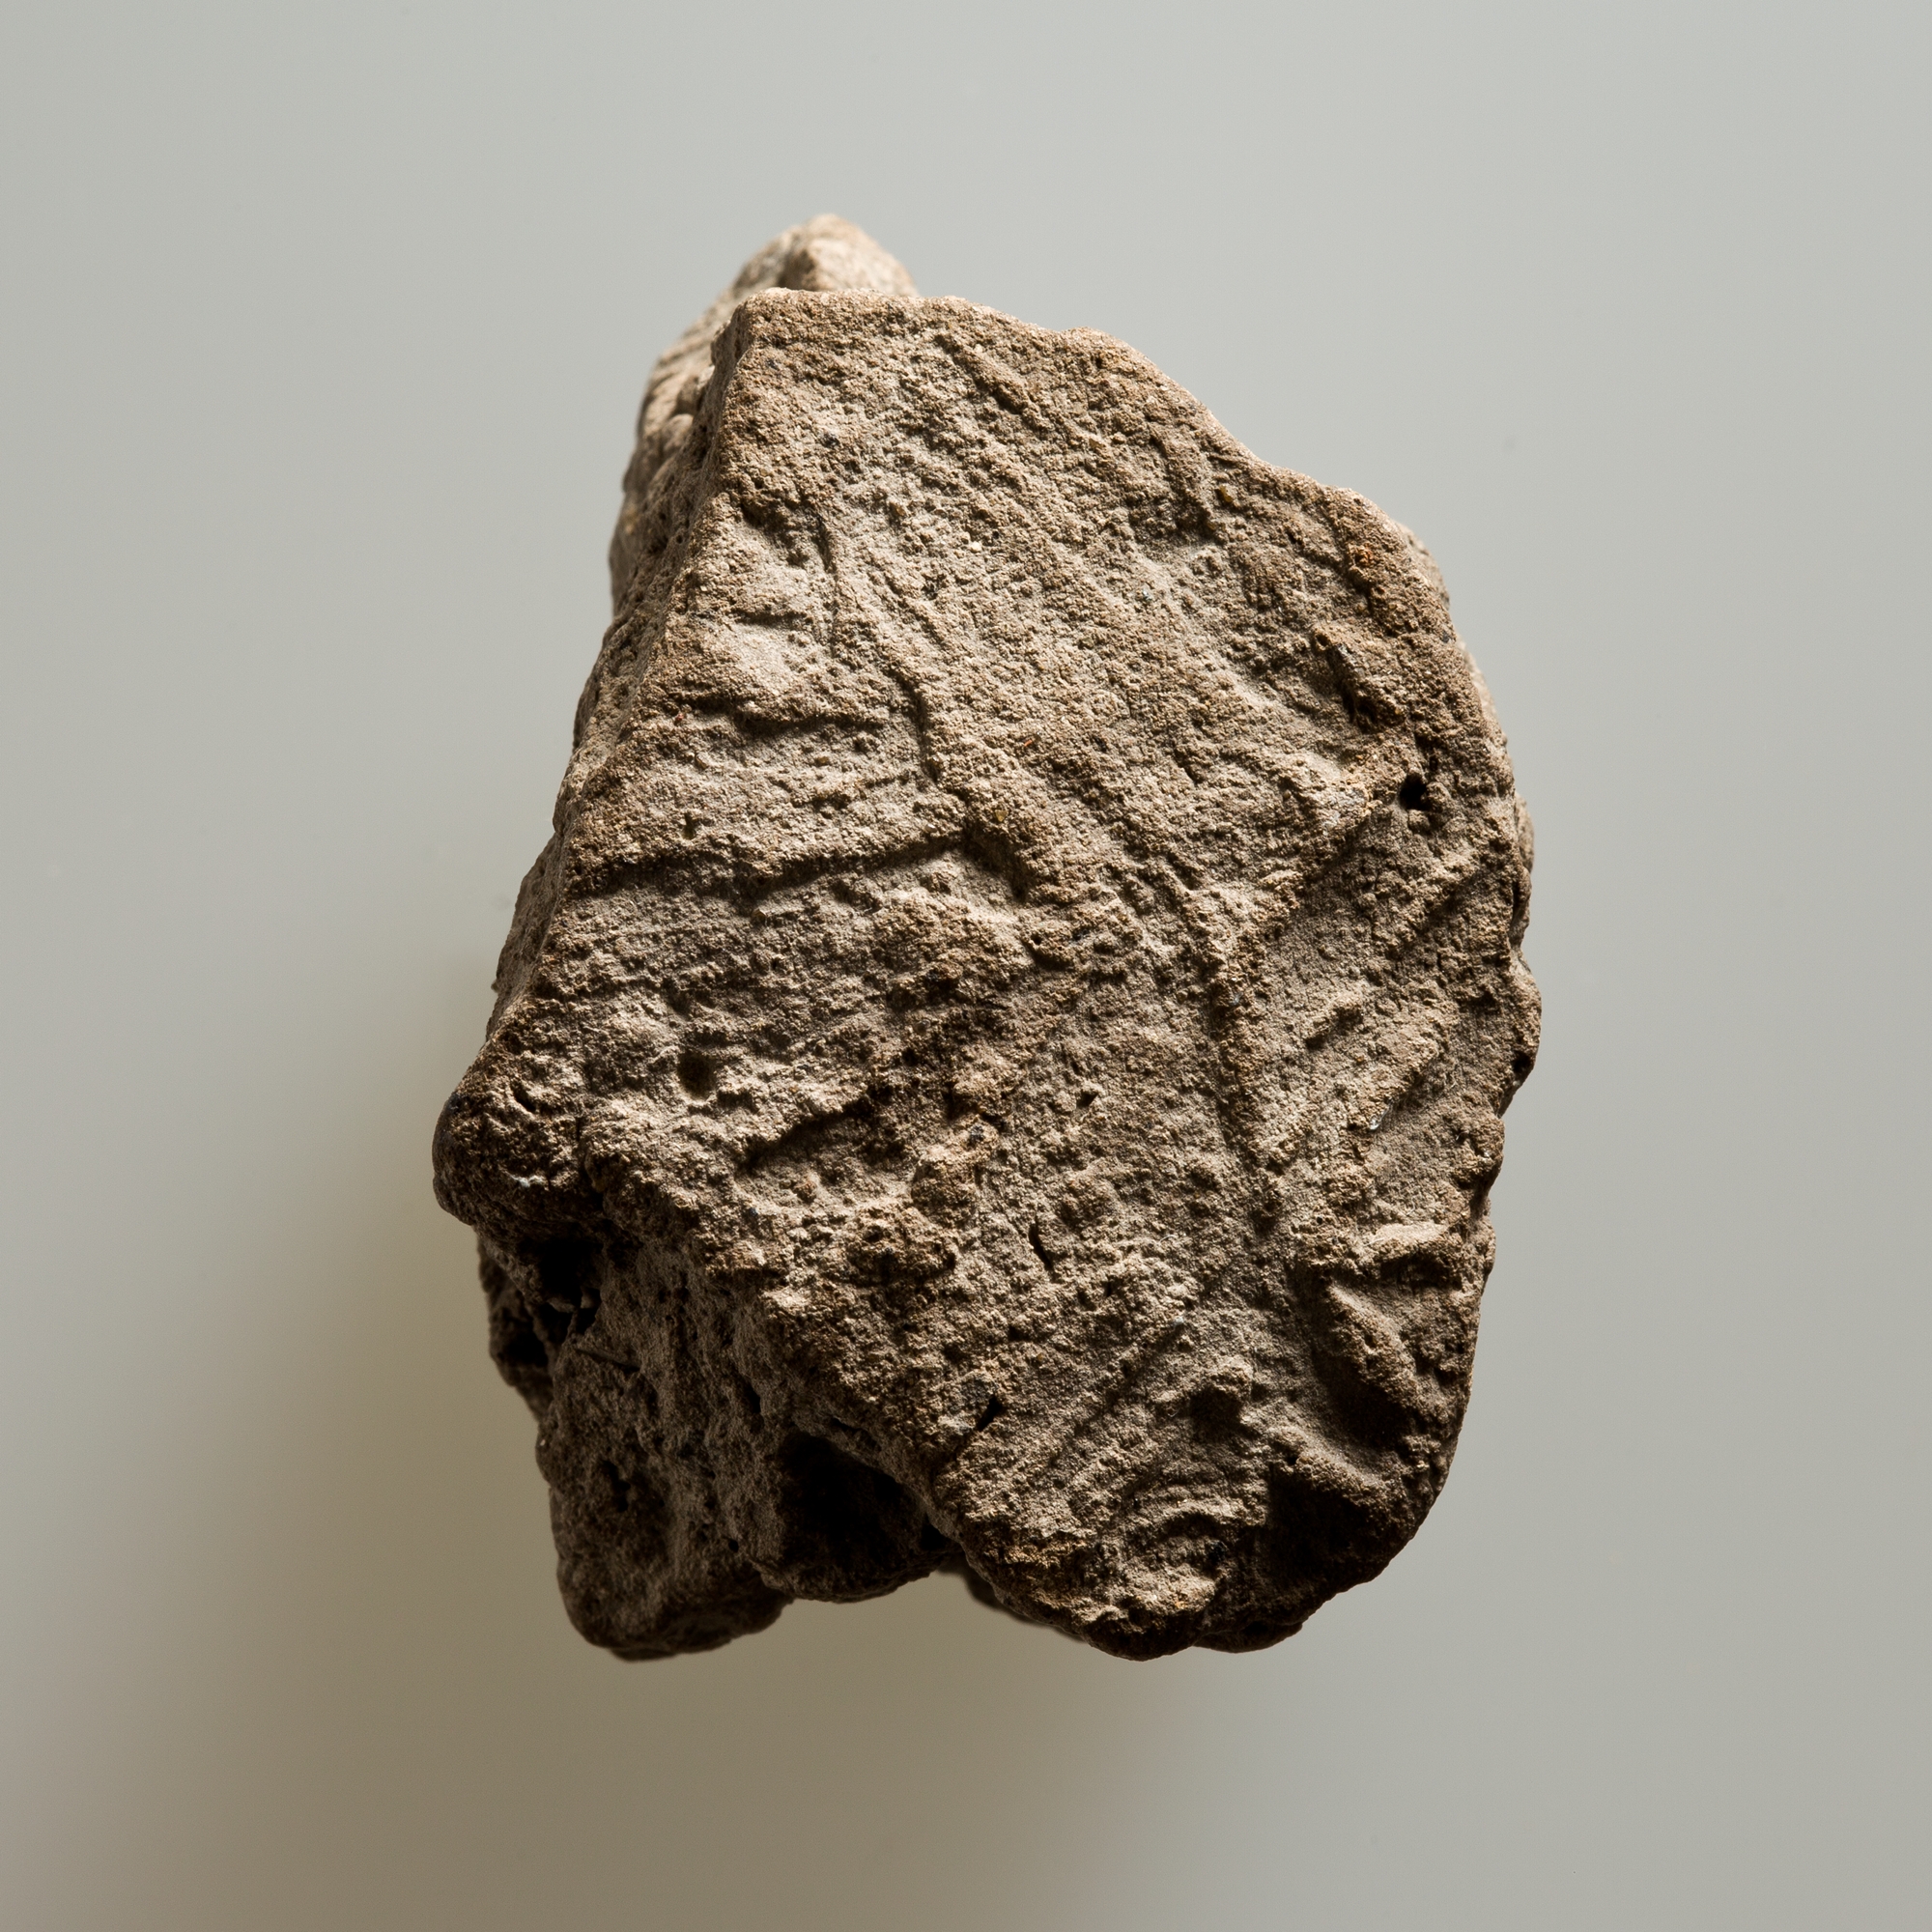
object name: sealing, jar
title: Mud jar sealing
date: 3200-2650 BCE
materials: clay, mud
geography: egypt